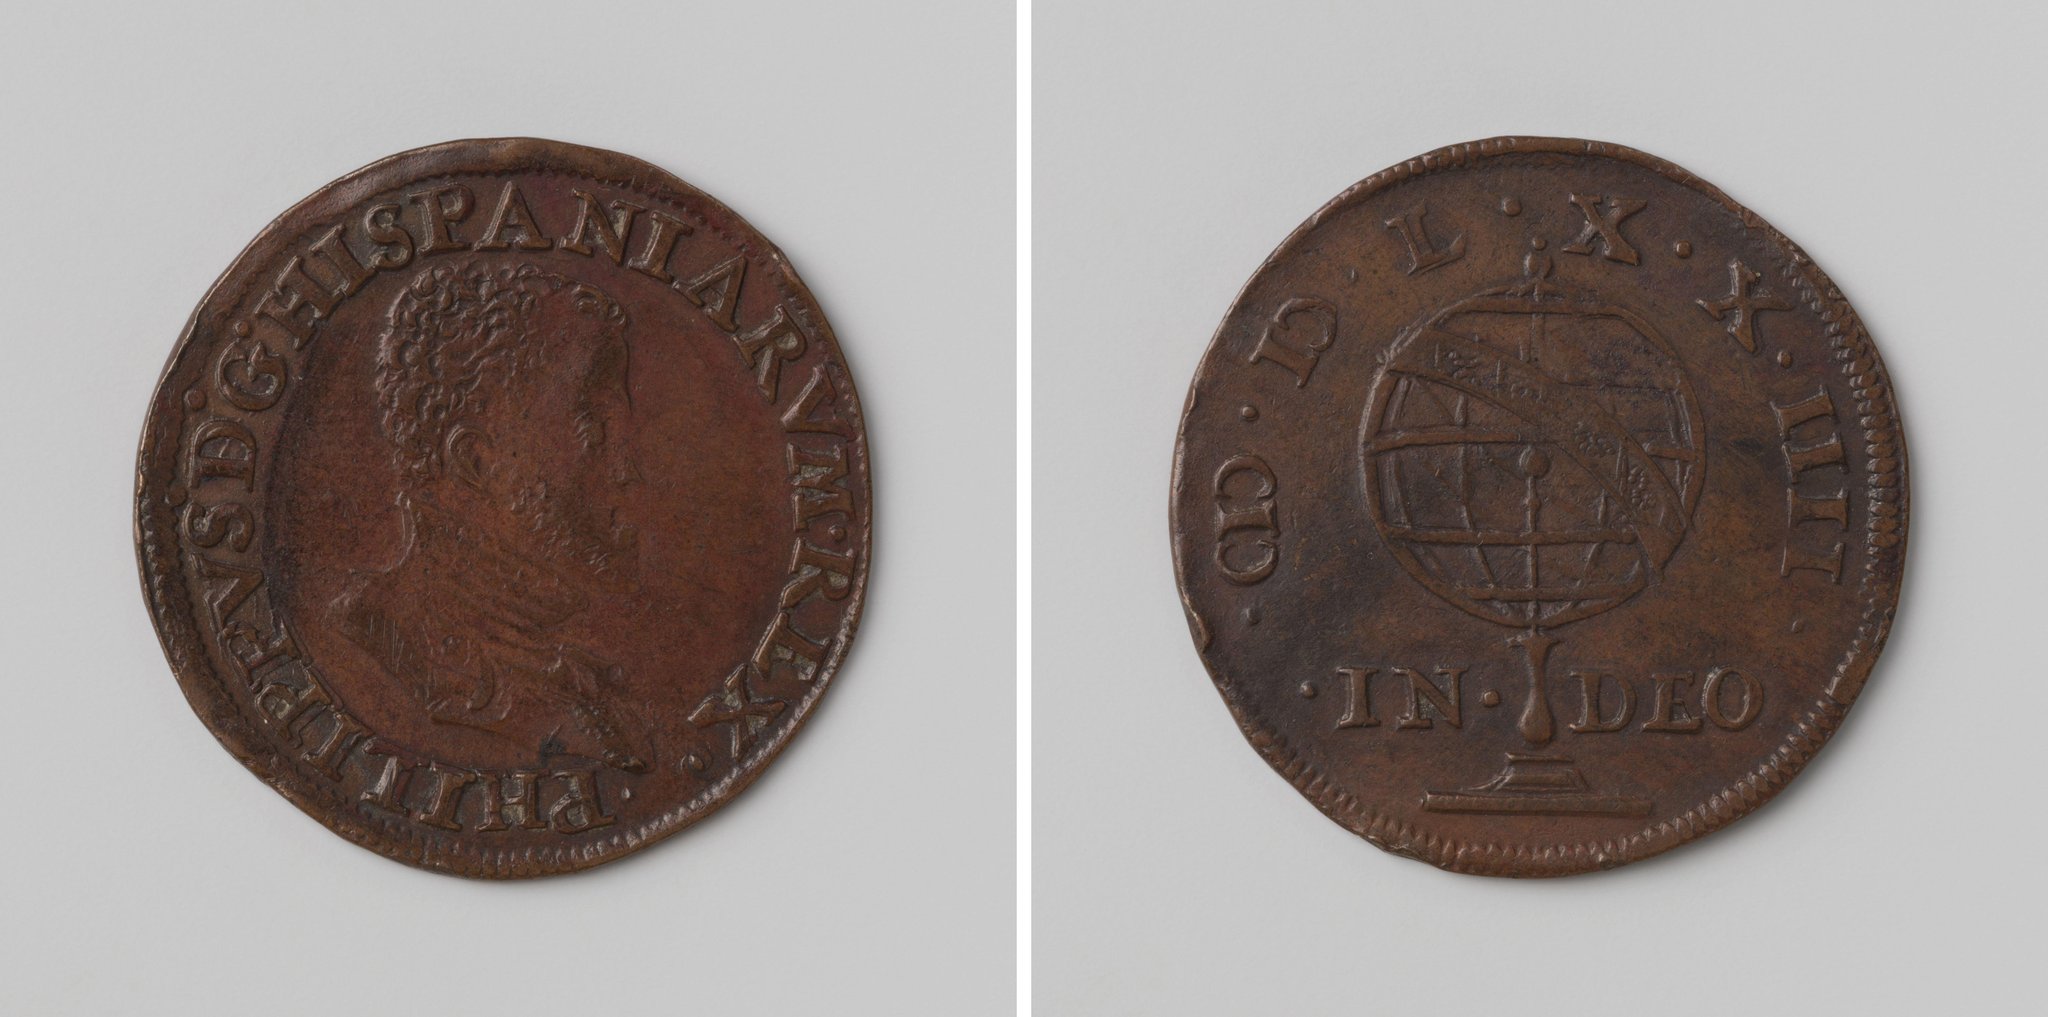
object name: jeton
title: Filips II, koning van Spanje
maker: Anonymous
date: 1574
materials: copper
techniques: striking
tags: philip ii of spain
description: Koperen penning. Voorzijde: borststuk man binnen omschrift. Keerzijde: wereldglobe op voetstuk boven opschrift binnen omschrift